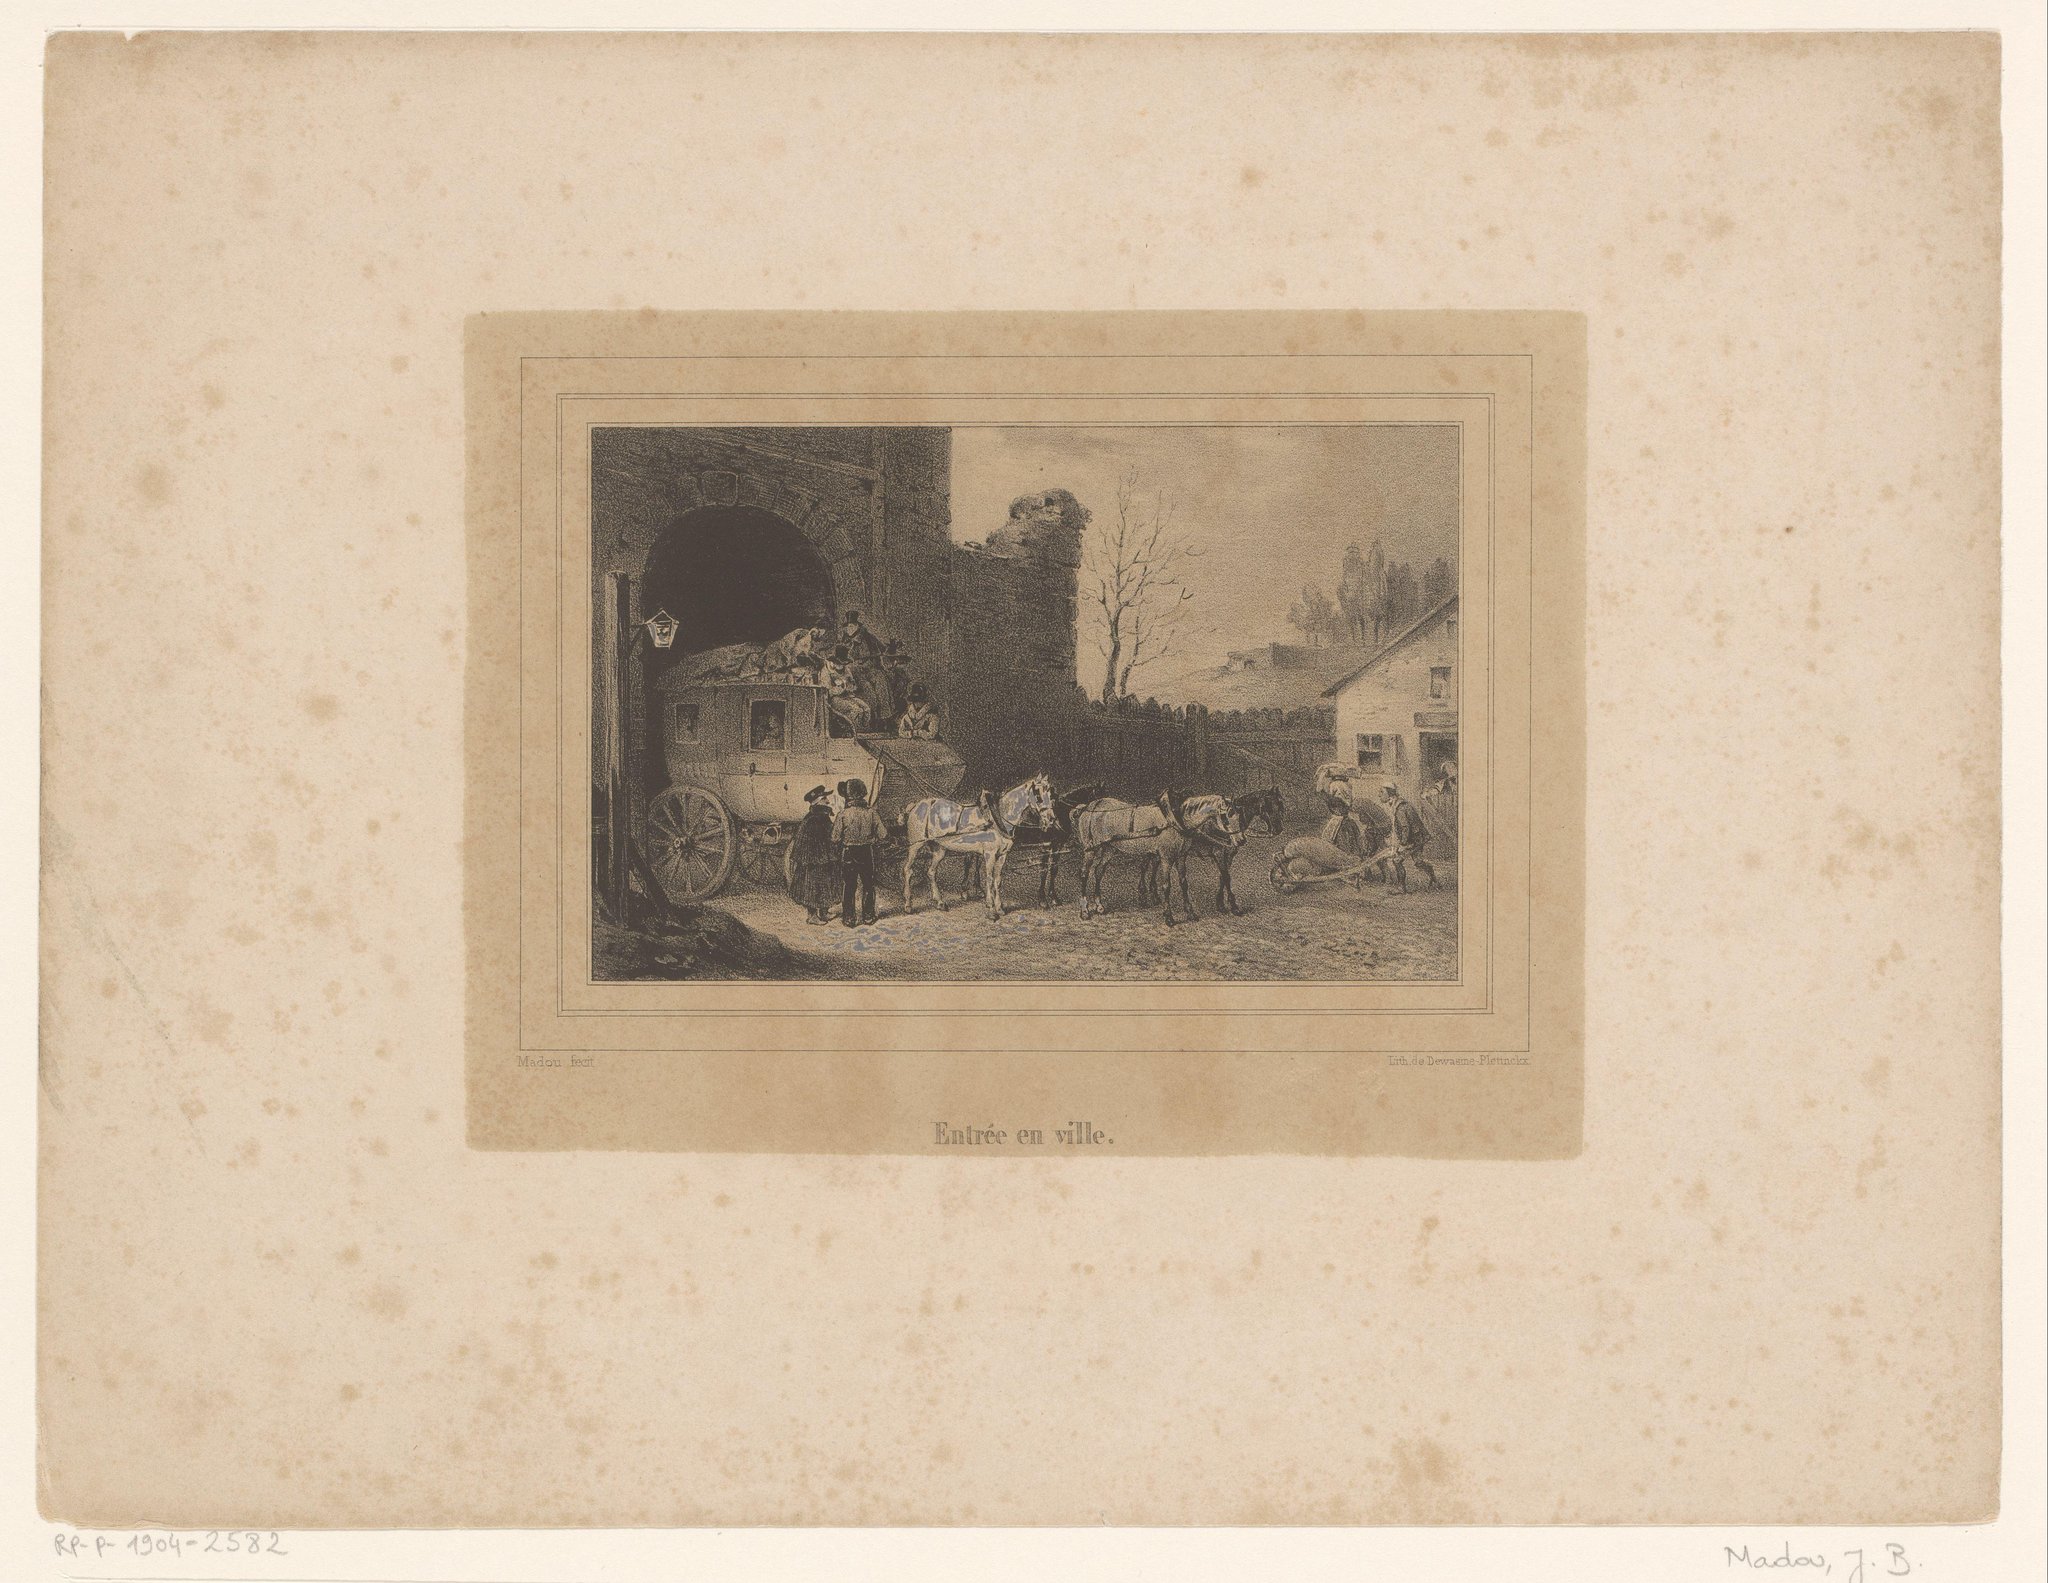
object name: print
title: Rijtuig rijdt via een poort een stad binnen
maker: lith. de la cour des ps. bas à bruxelles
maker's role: printer, publisher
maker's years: 1797-1851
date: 1827-1851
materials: paint, paper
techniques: brush, lithograph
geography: brussels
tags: village-gate, four-wheeled vehicle drawn by more than three animals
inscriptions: collector's mark: Lugt 2228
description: Prent behoort mogelijk tot de serie 'Douze sujets composés et dessinés sur pierre par Madou de Bruxelles'.